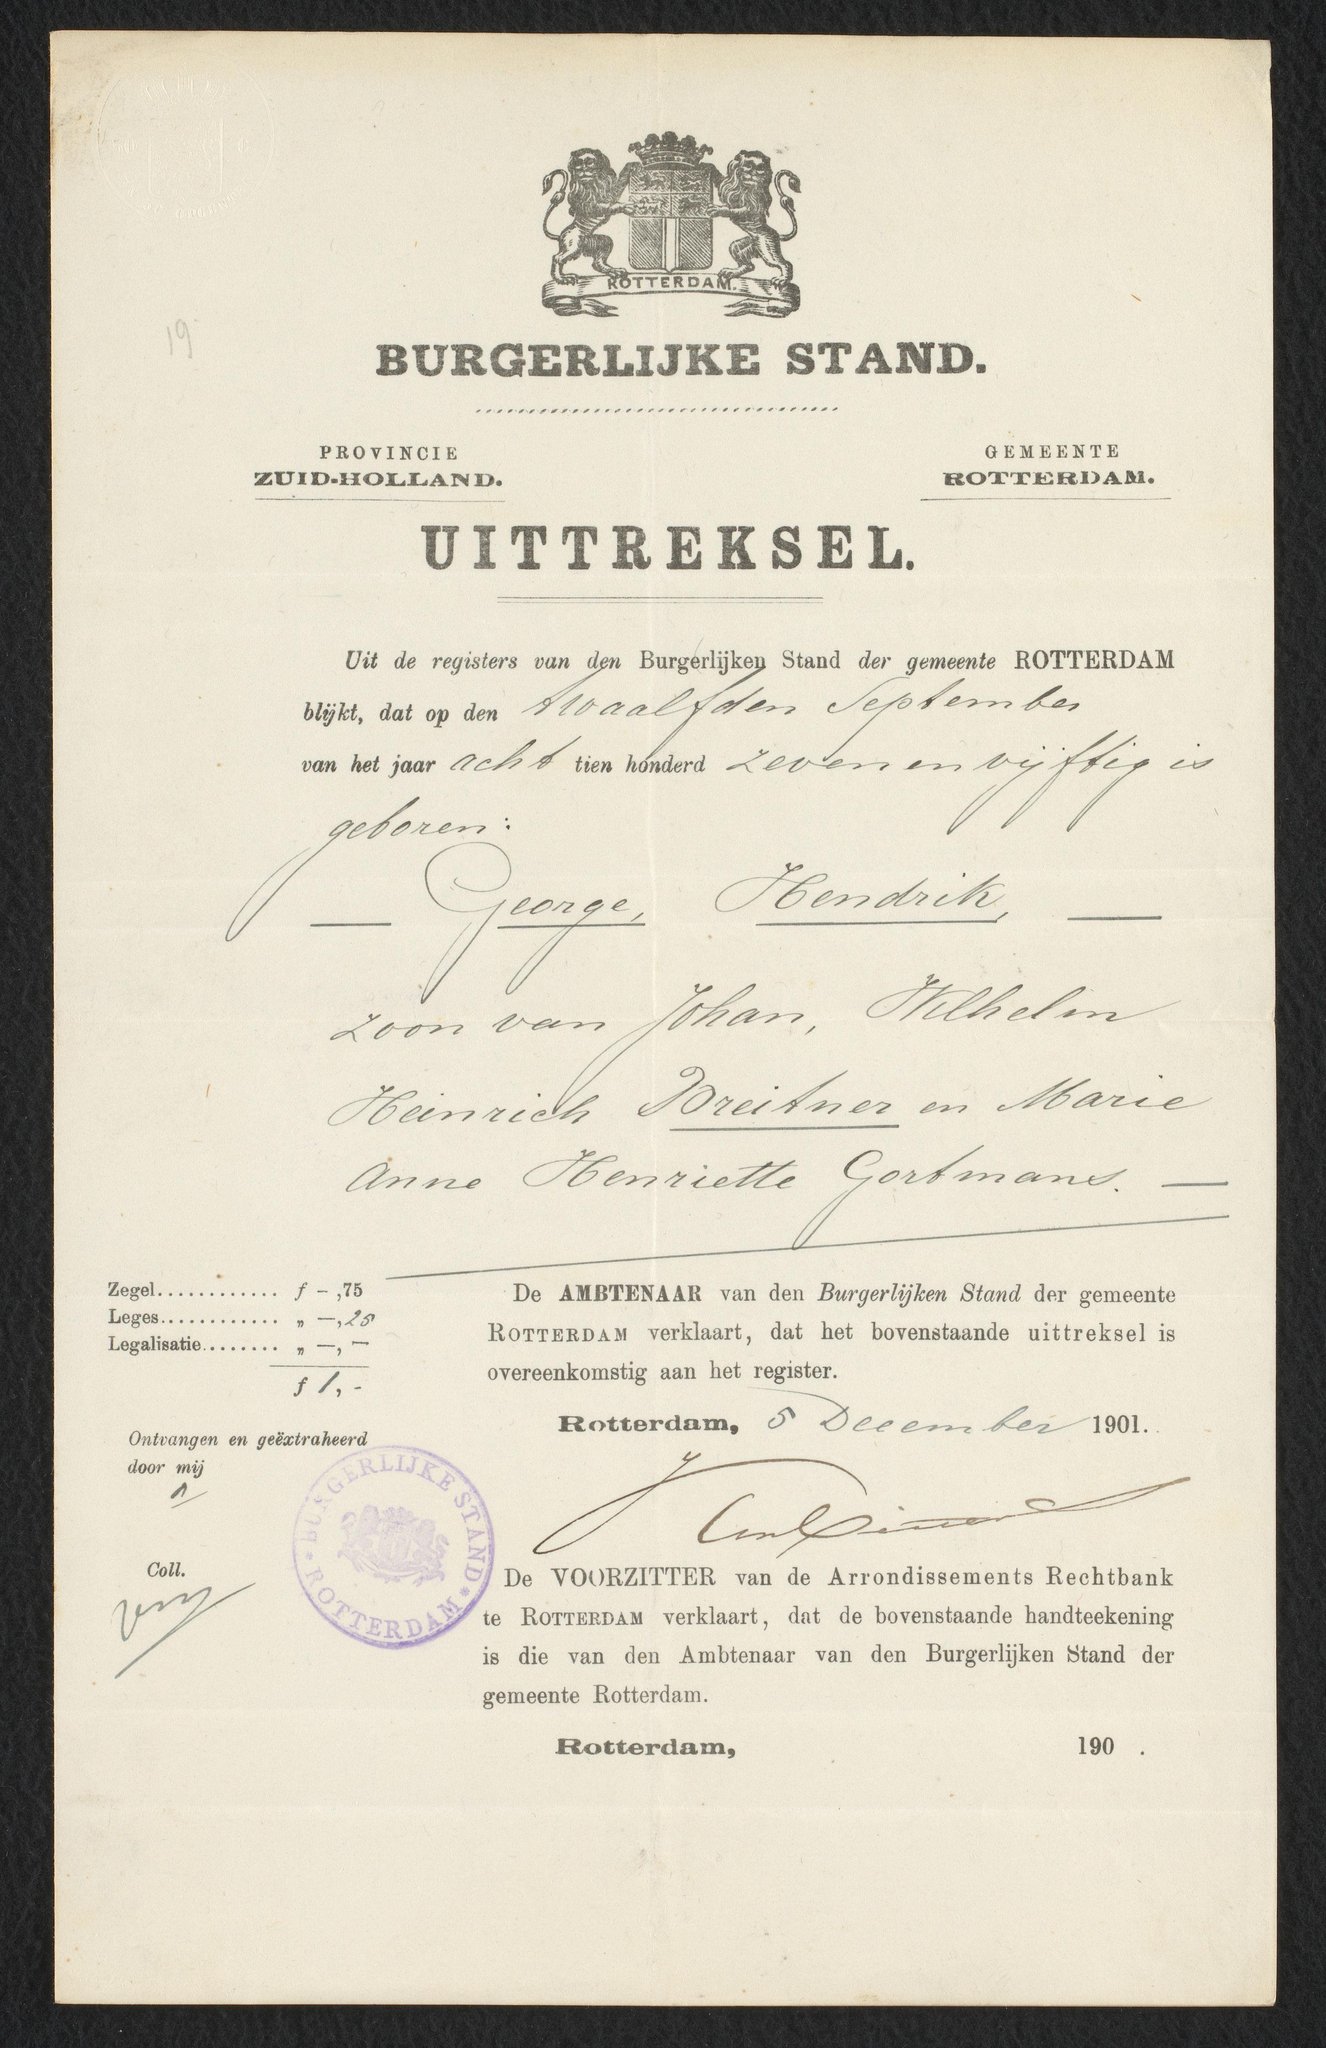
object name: document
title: Uittreksel uit het geboorteregister van George Hendrik Breitner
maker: Anonymous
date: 1901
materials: ink, paper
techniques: blind stamped, printing, letterpress printing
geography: rotterdam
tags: rotterdam, print maker, draughtsman, george hendrik breitner, distribution of awards ~ art contest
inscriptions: inscription: ‘Burgerlijke Stand/ uittreksel’